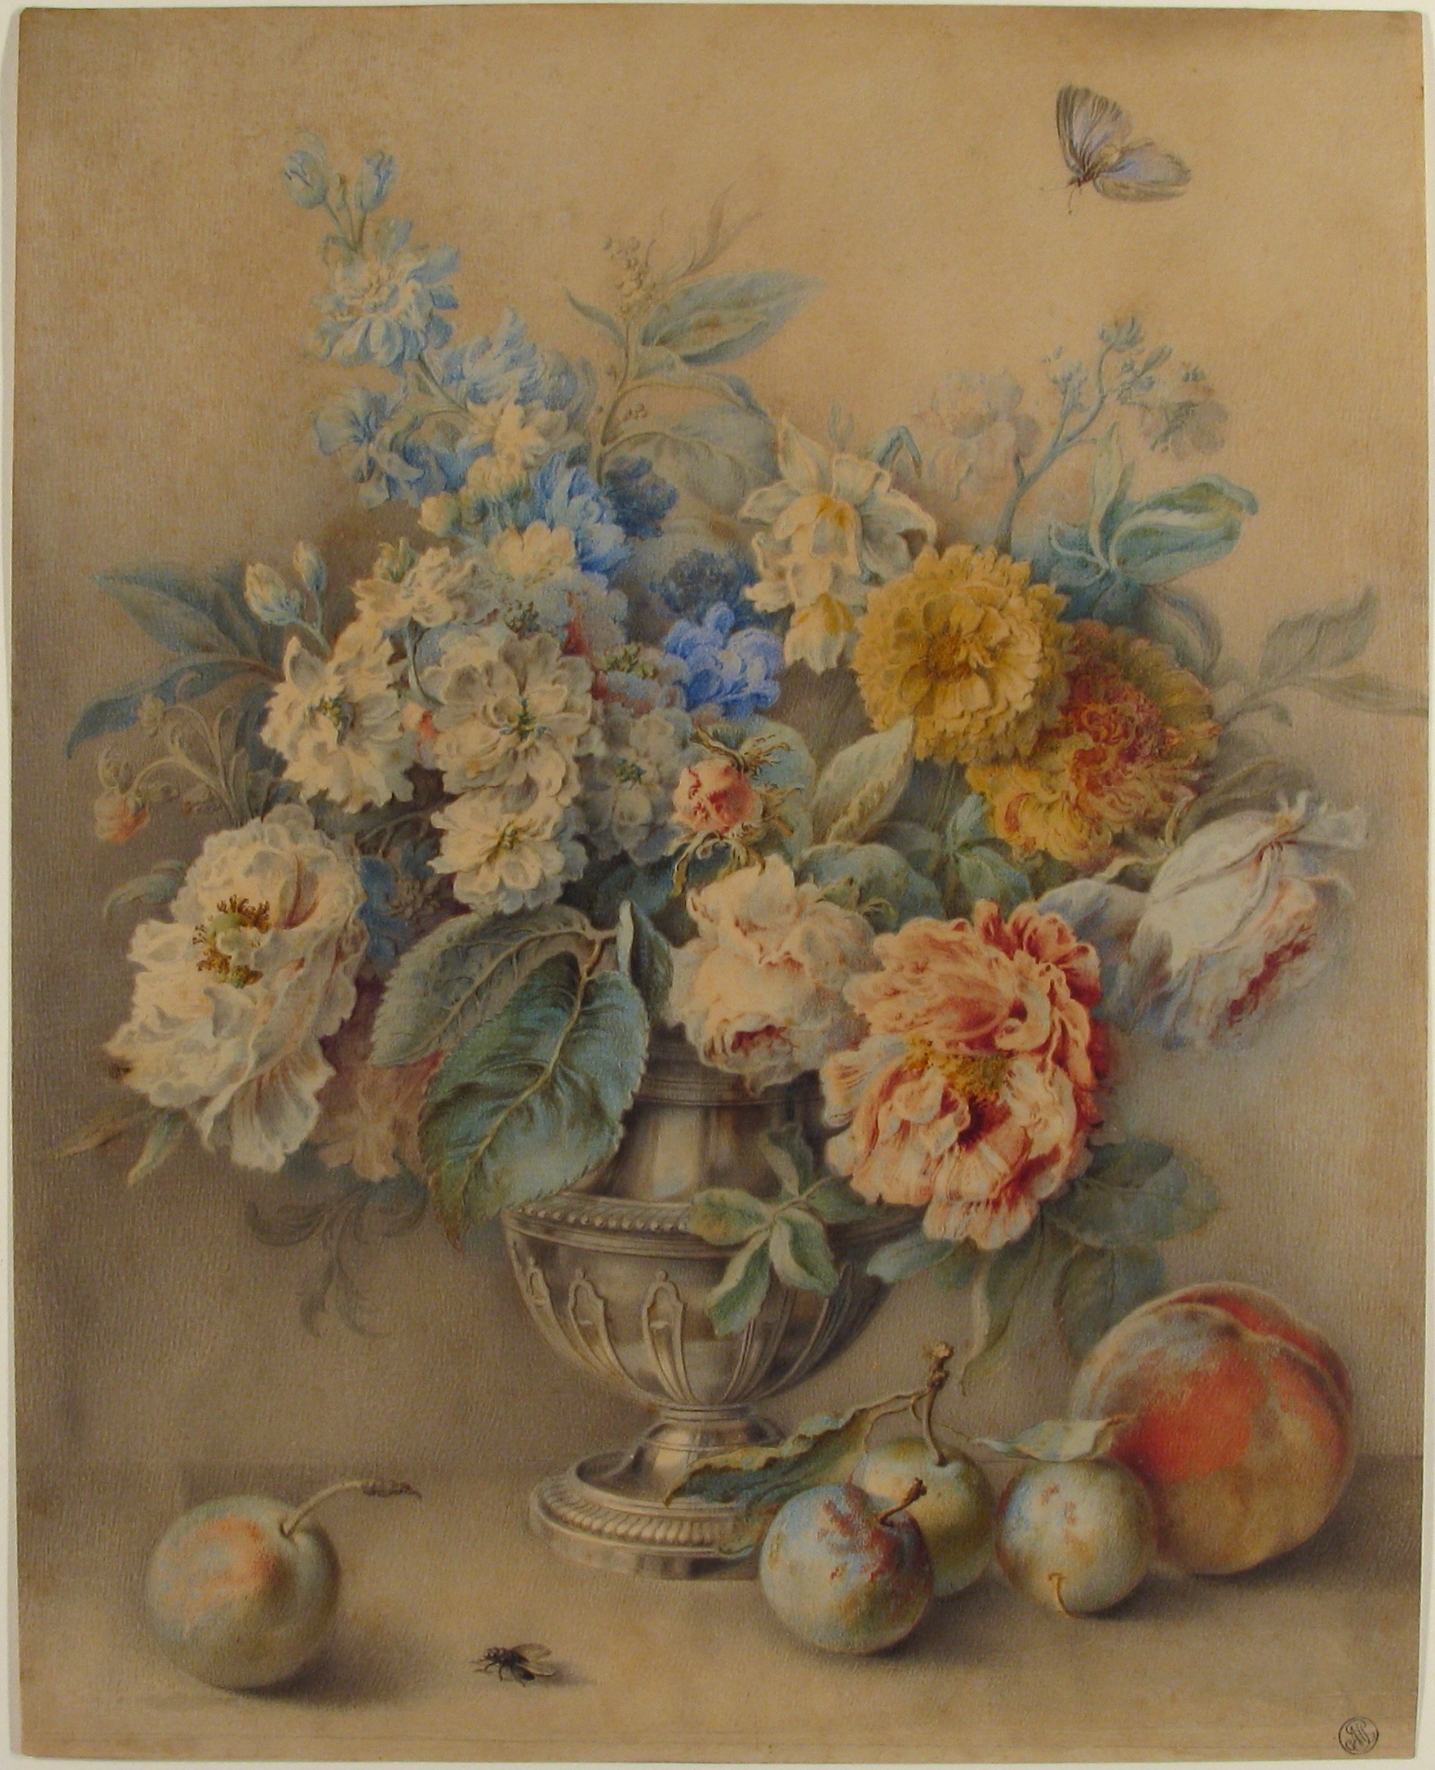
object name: drawing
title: Flowers in a Silver Caster, Fruit in the Foreground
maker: jacques andré portail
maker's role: artist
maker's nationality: french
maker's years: 1695-1759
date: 1701-1800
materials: graphite, watercolor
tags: fruit,butterflies,flowers